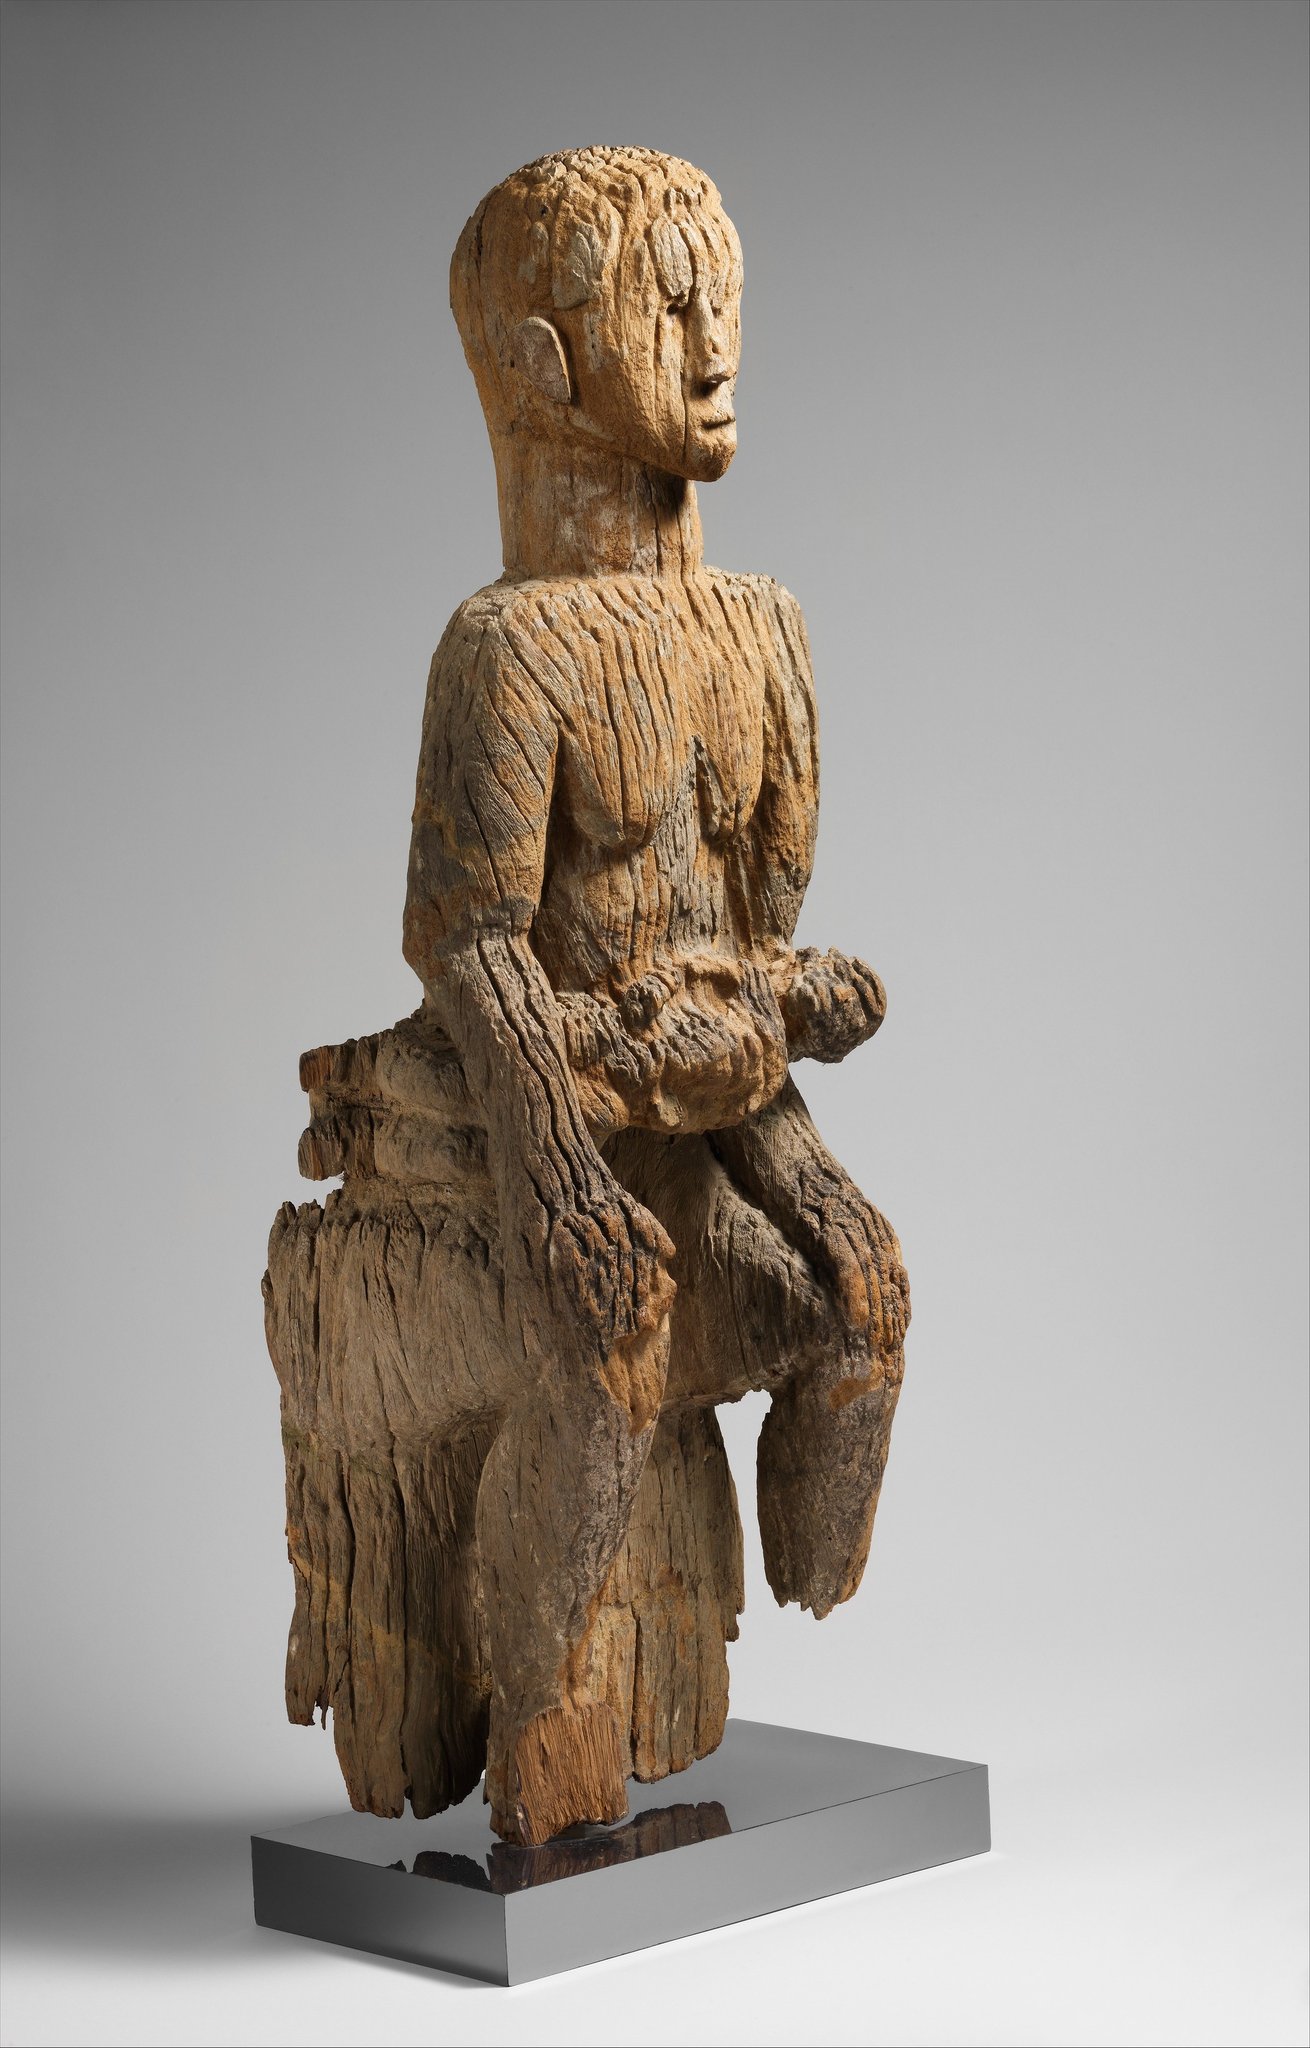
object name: mother and child figure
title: Seath mother and child from an ikoro drum(?)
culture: mbembe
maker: mbembe artist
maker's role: artist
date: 1401-1700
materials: pigment, wood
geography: nigeria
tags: women